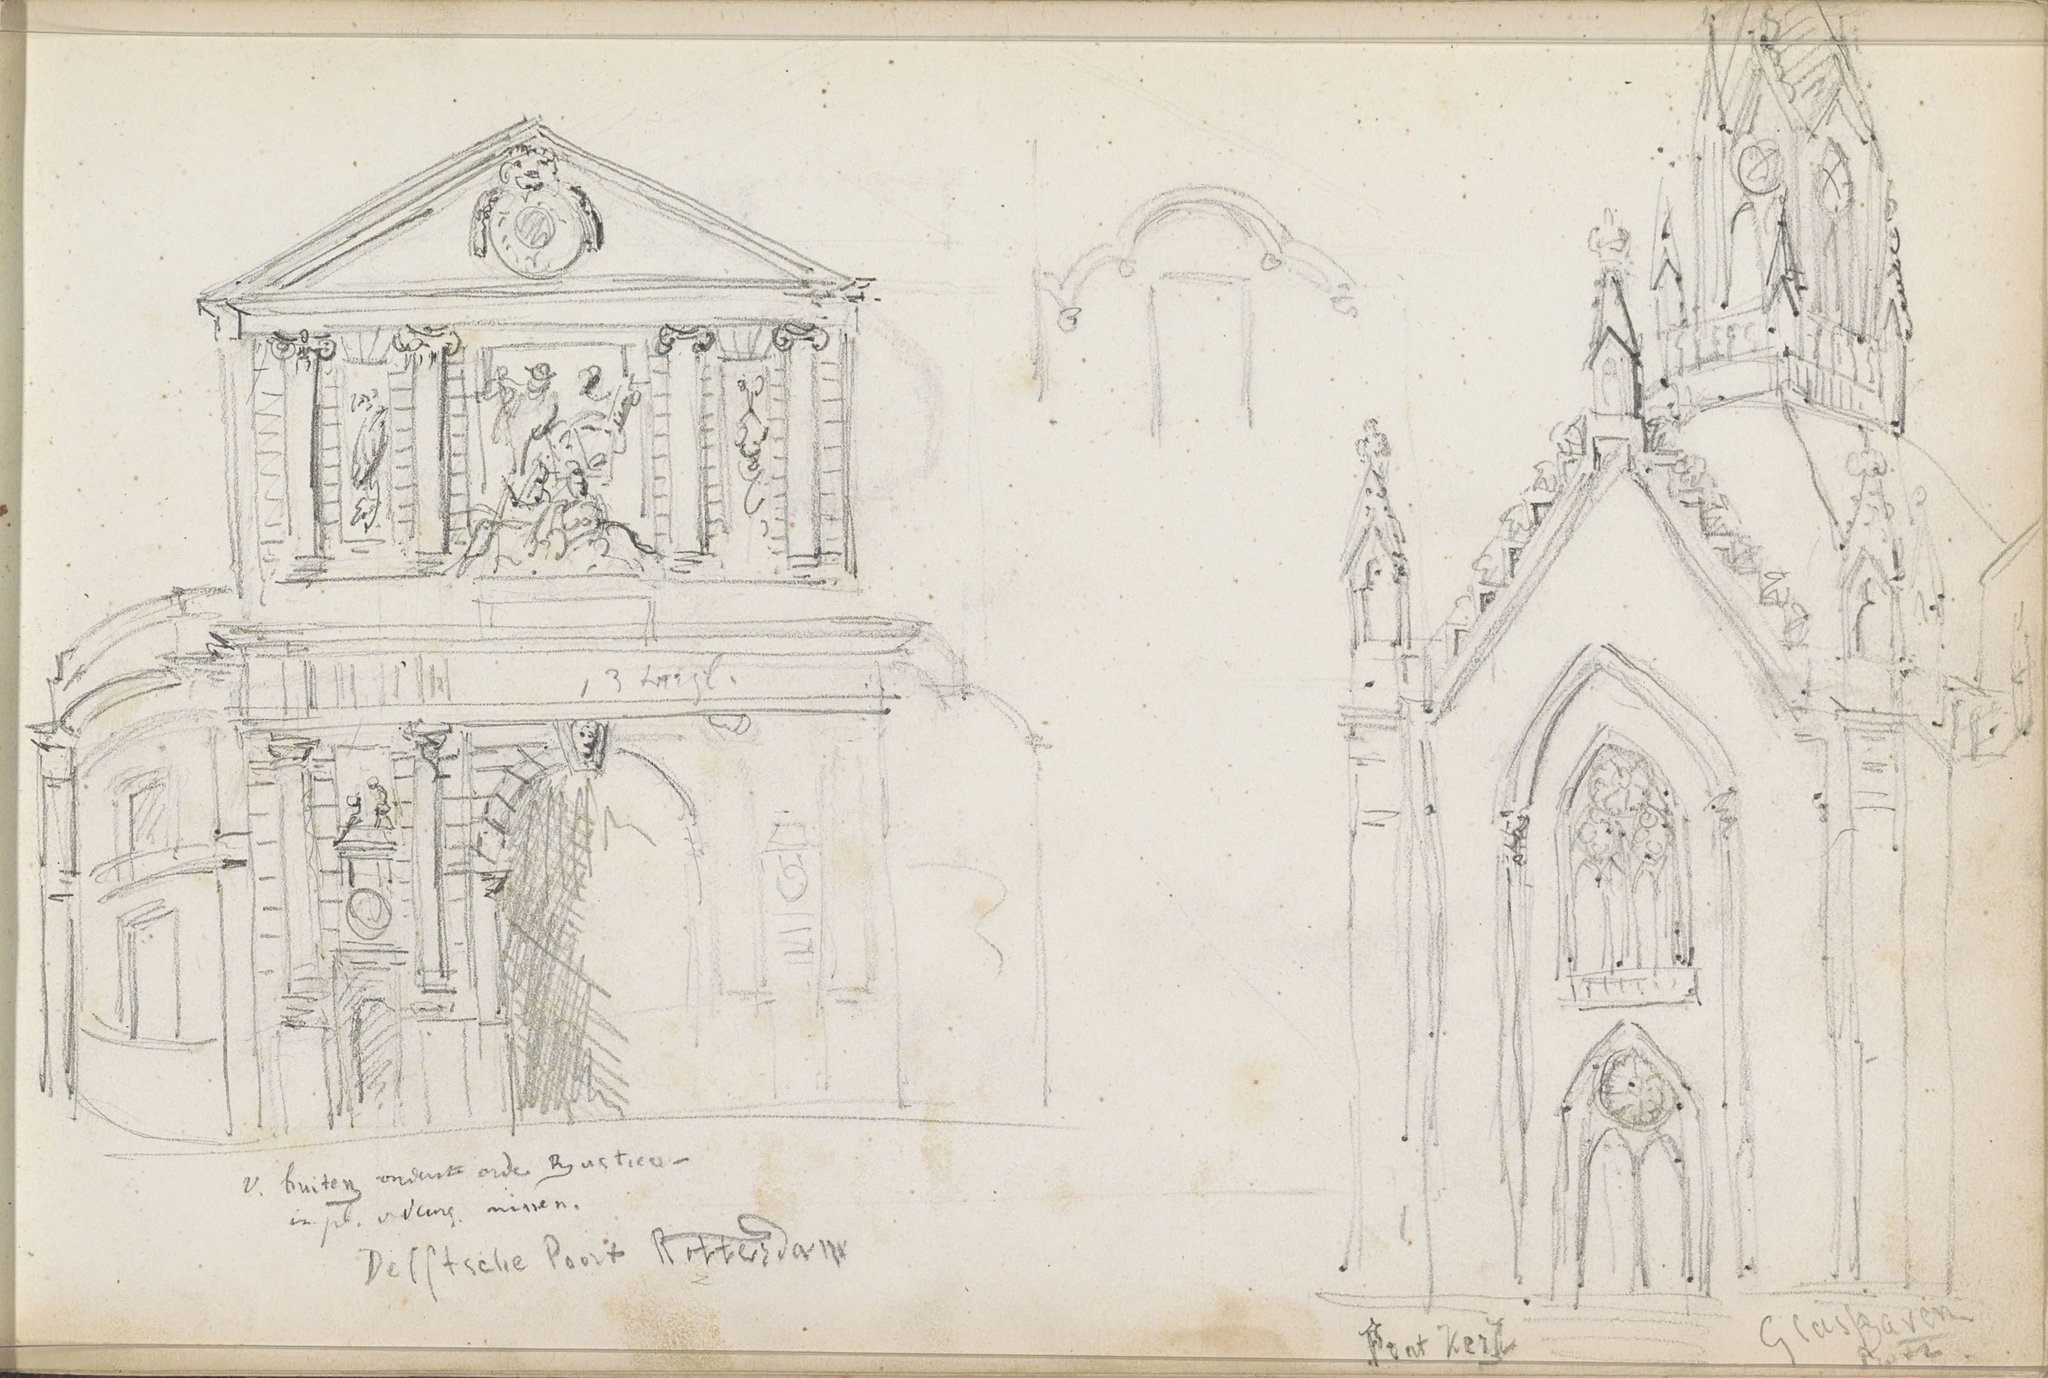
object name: sketchbook leaf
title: Delftsche Poort en Zuiderkerk te Rotterdam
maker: isaac gosschalk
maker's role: draughtsman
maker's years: 1838-1907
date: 1862-1867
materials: paper, pencil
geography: rotterdam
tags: church (exterior), gate, entrance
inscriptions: annotation: ‘[...]/ Delftsche Poort Rotterdam/ Pont Kerk Glashaven/ Rott’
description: Blad 21 recto uit een schetsboek met 58 bladen.